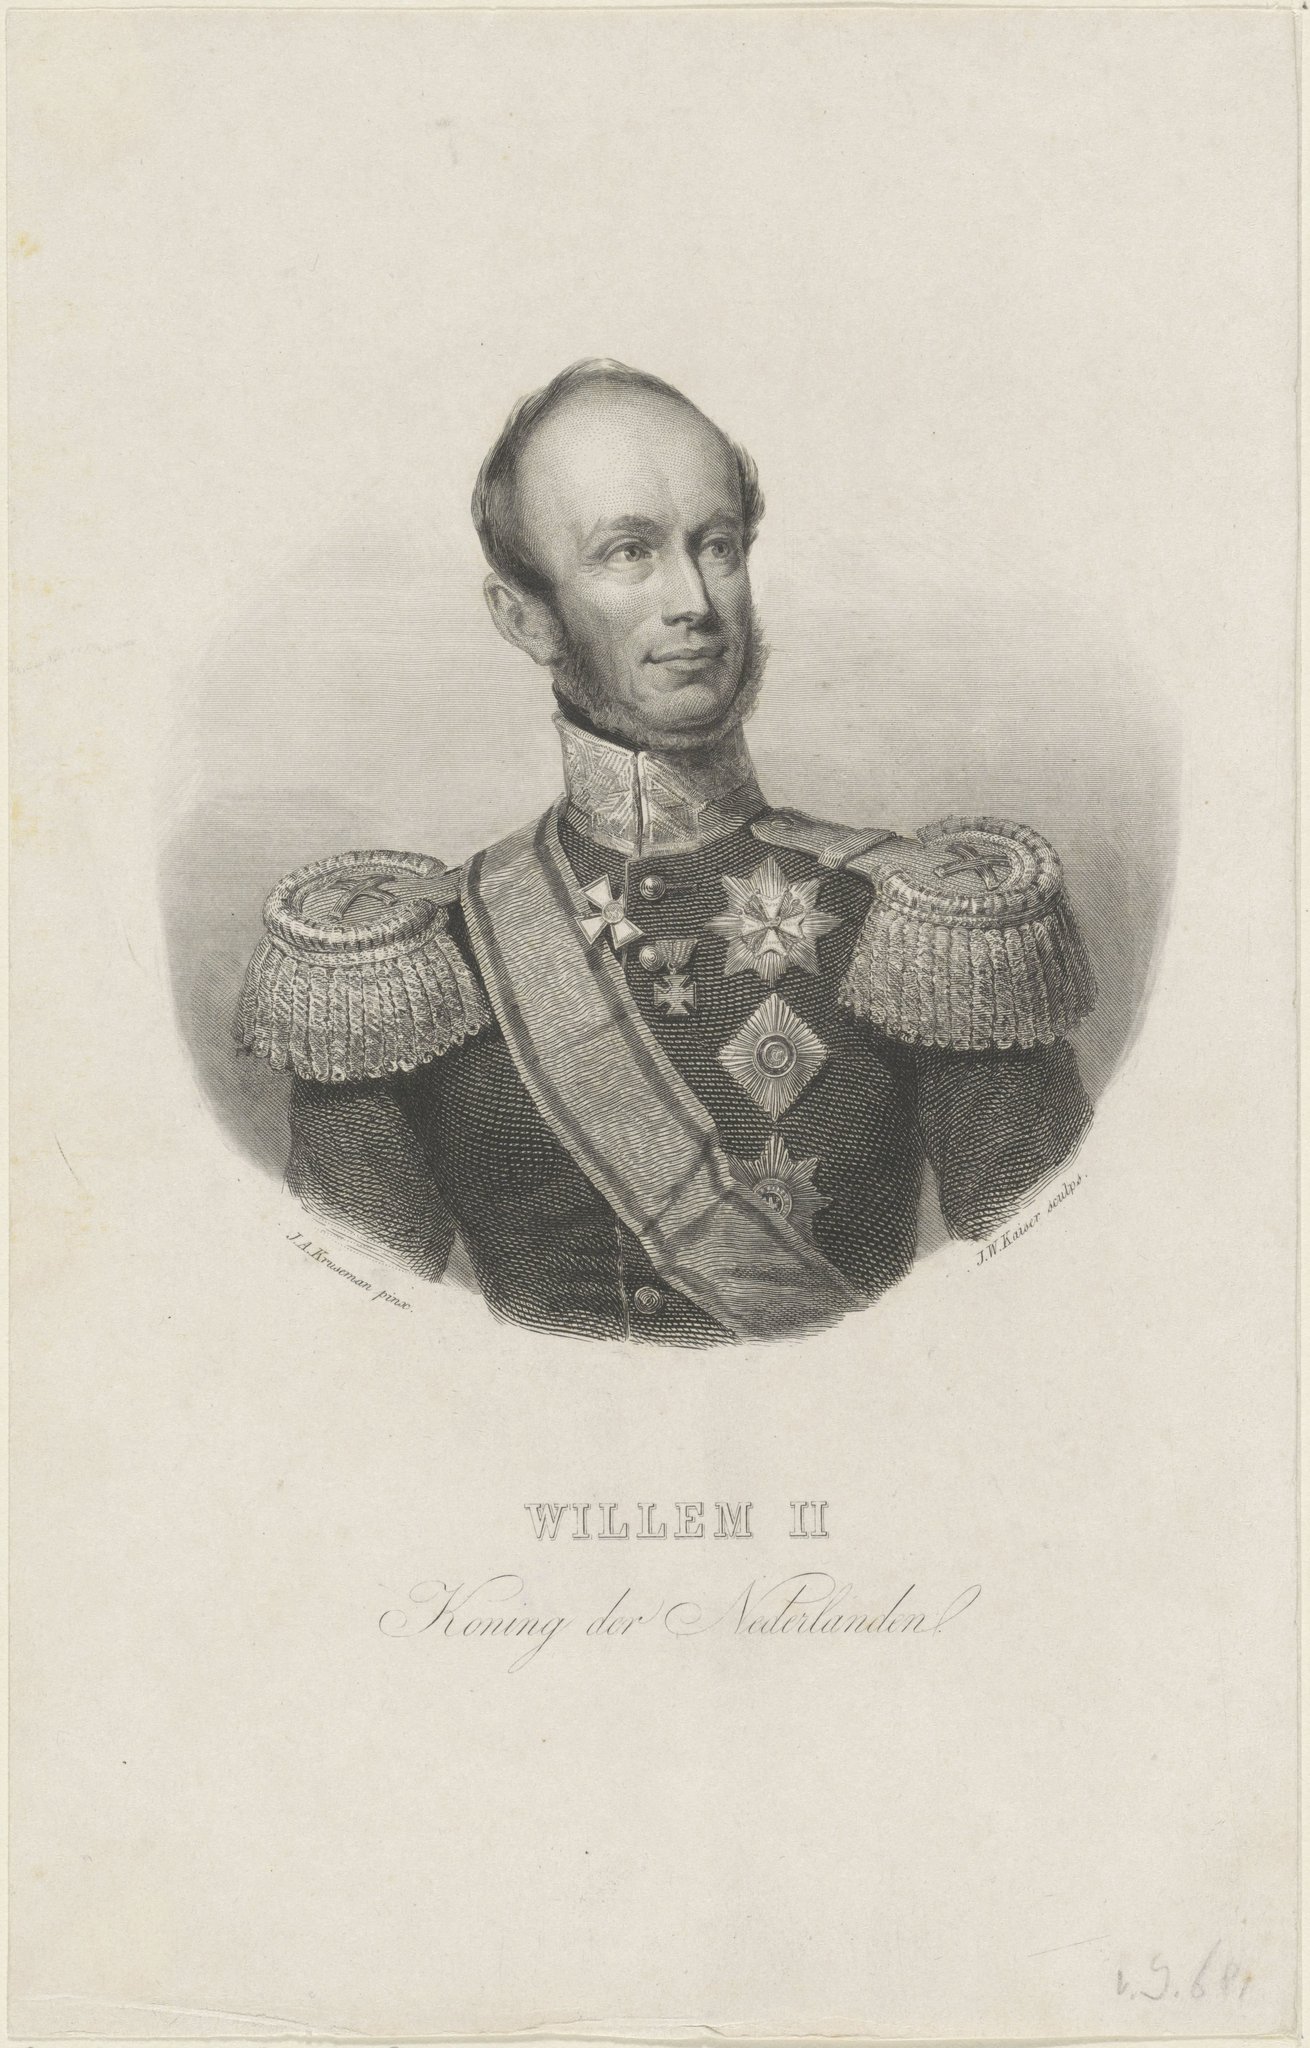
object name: print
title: Portret van Willem II, koning der Nederlanden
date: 1840-1900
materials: paper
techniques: engraving, etching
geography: netherlands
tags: the hague, william ii of the netherlands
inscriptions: collector's mark: Lugt 2166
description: De hier vermelde titel verwijst naar de hoogst verkregen titel van de geportretteerde, niet per se naar de titel die de geportretteerde op deze voorstelling draagt.